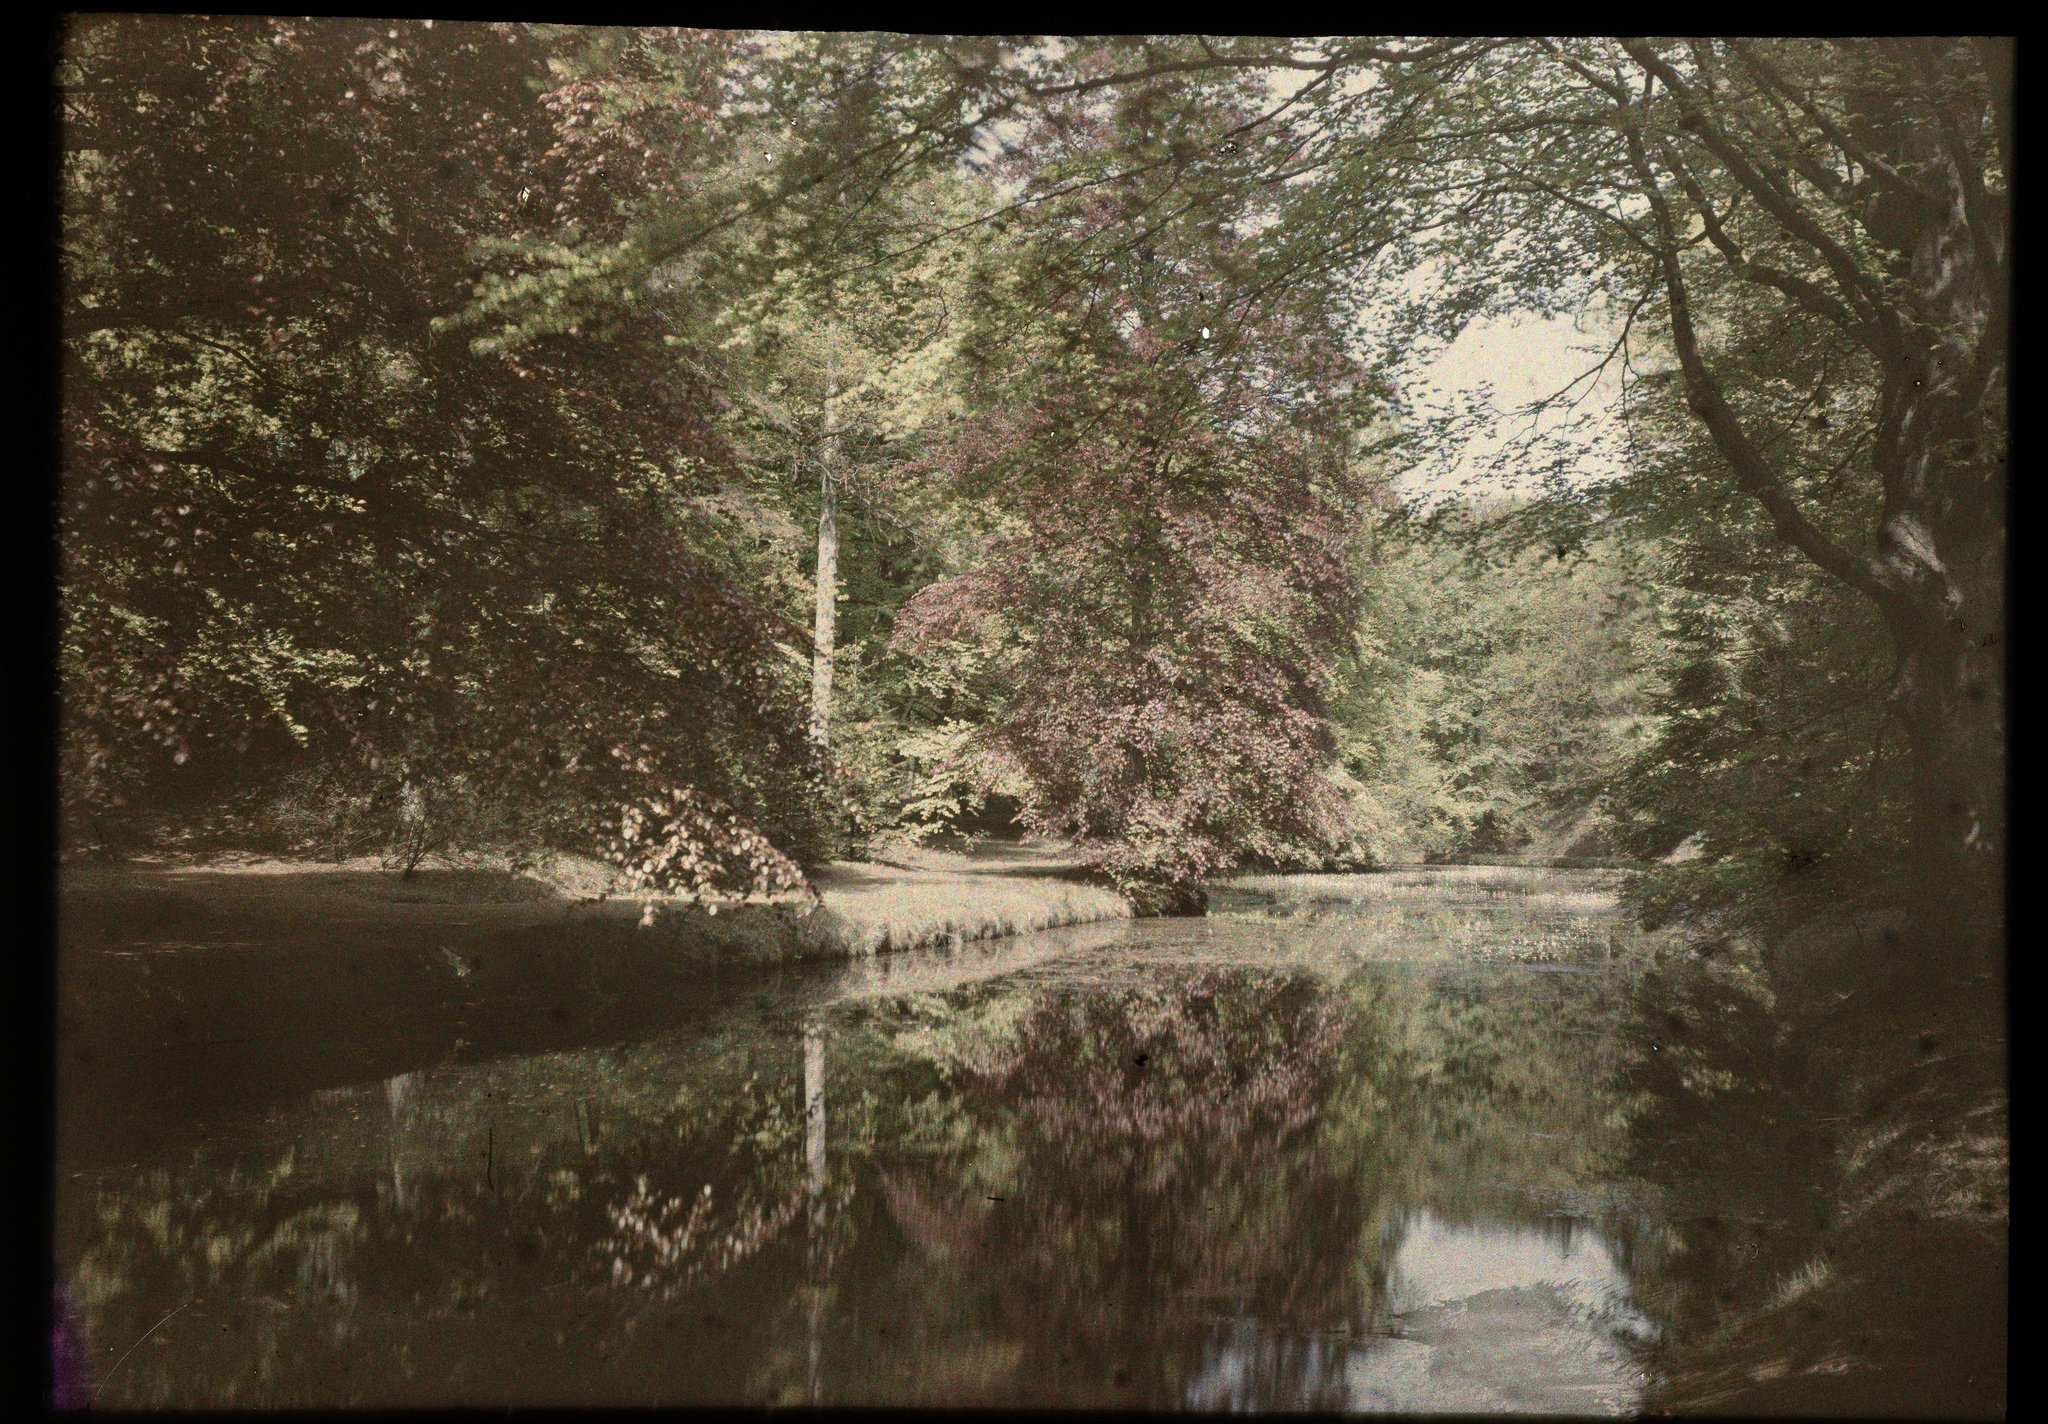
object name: photograph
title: Gezicht over water in een bos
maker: adolphe burdet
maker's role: fotograaf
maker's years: 1860-1940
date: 1907-1930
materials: glass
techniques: autochrome process, slide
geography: netherlands